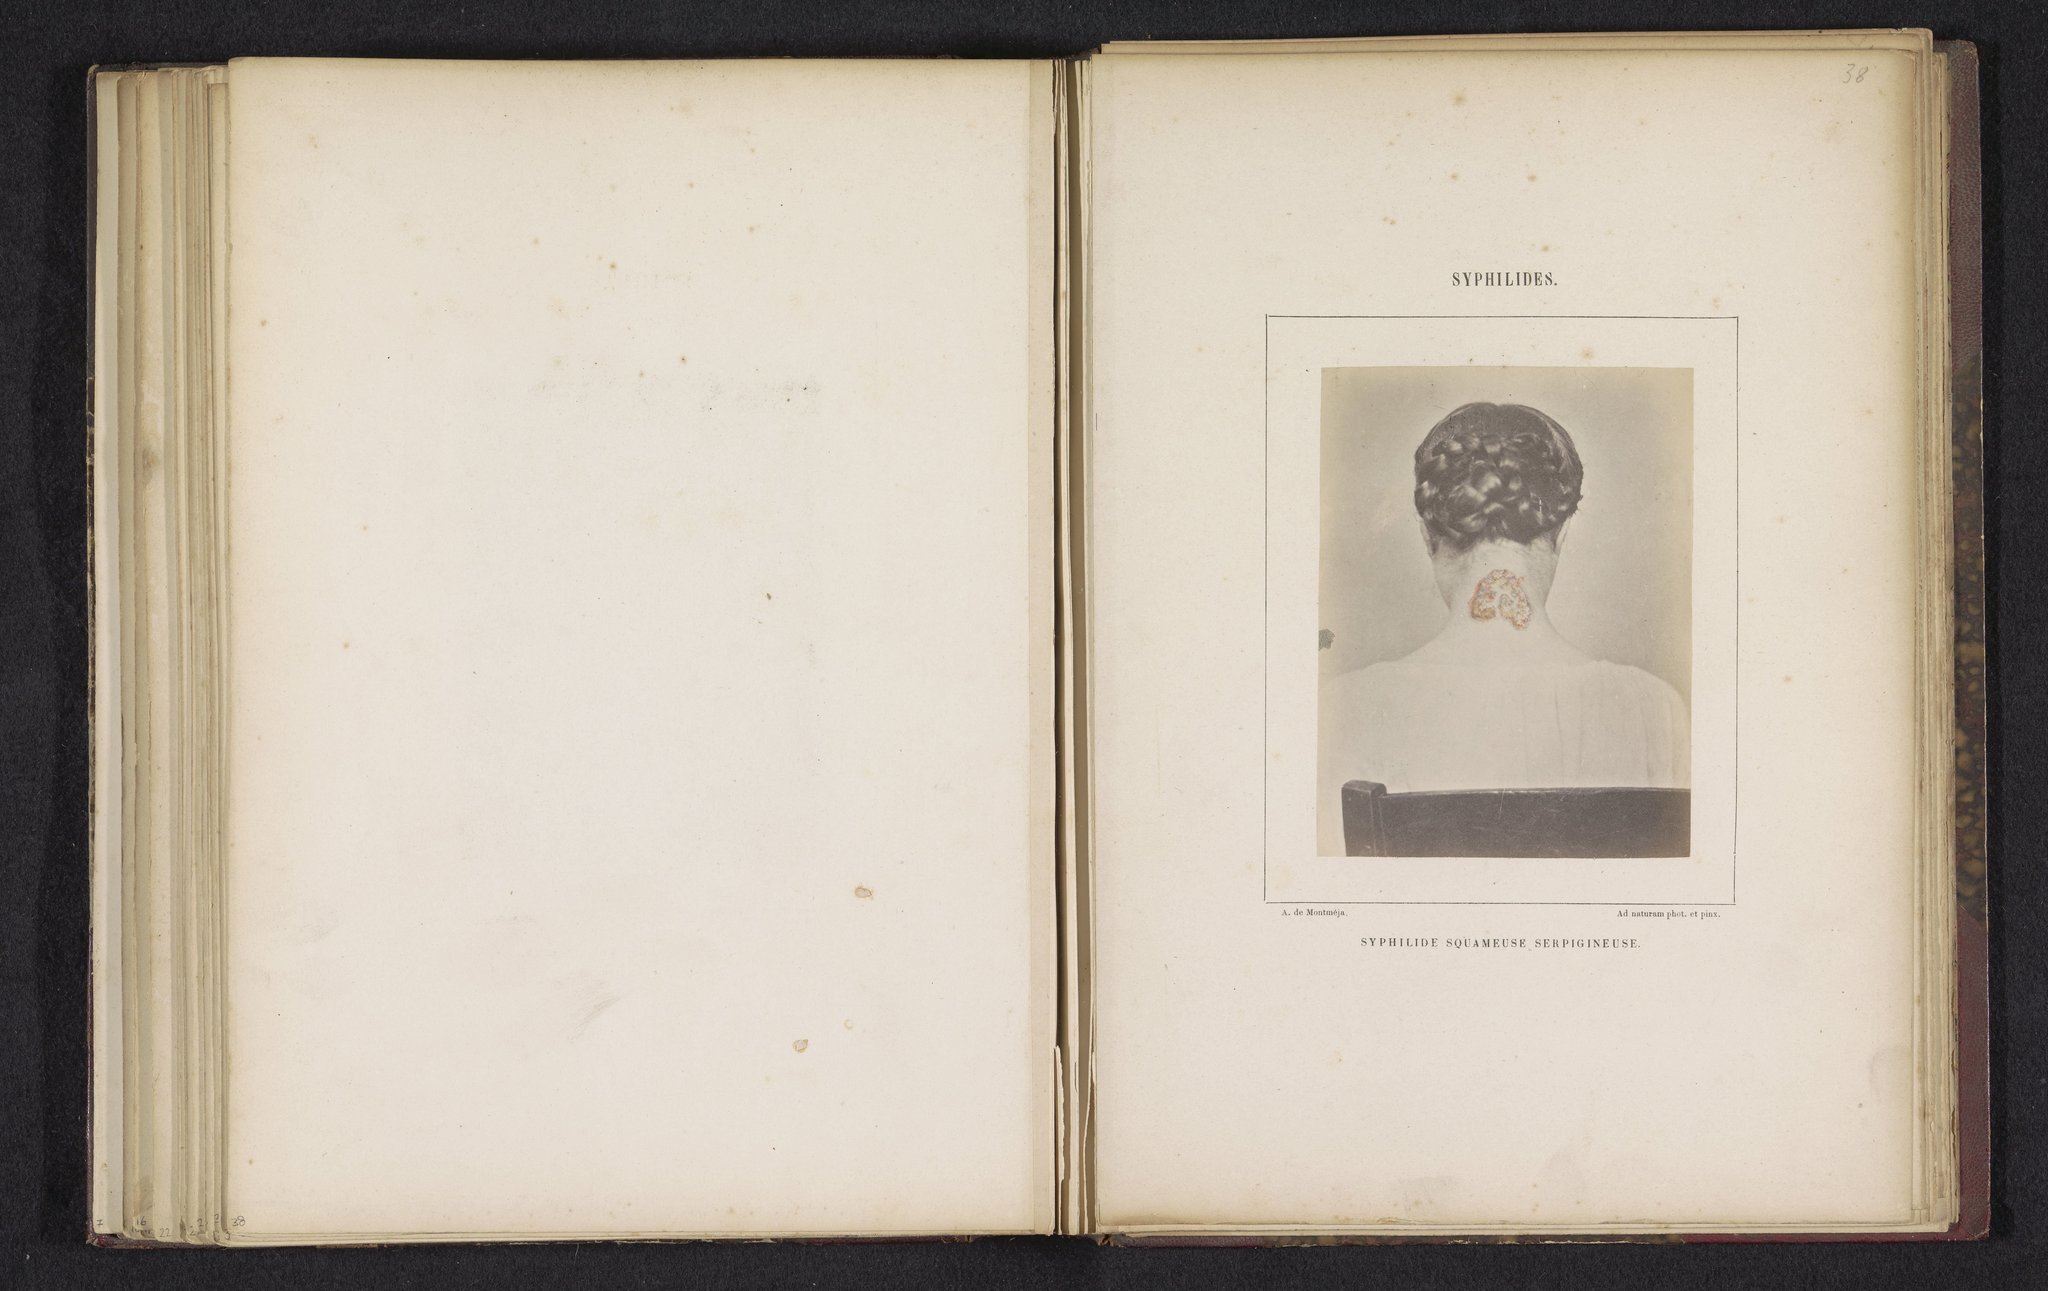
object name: page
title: Syphilide squameuse serpigineuse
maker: a. de montméja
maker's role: arts, fotograaf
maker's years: 1841-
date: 1860-1868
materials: photographic support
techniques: albumen print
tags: skin and venereal diseases: syphilis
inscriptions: inscription: ‘Syphilides.’, number: ‘38’, inscription: ‘Ad naturam phot. et pinx.’